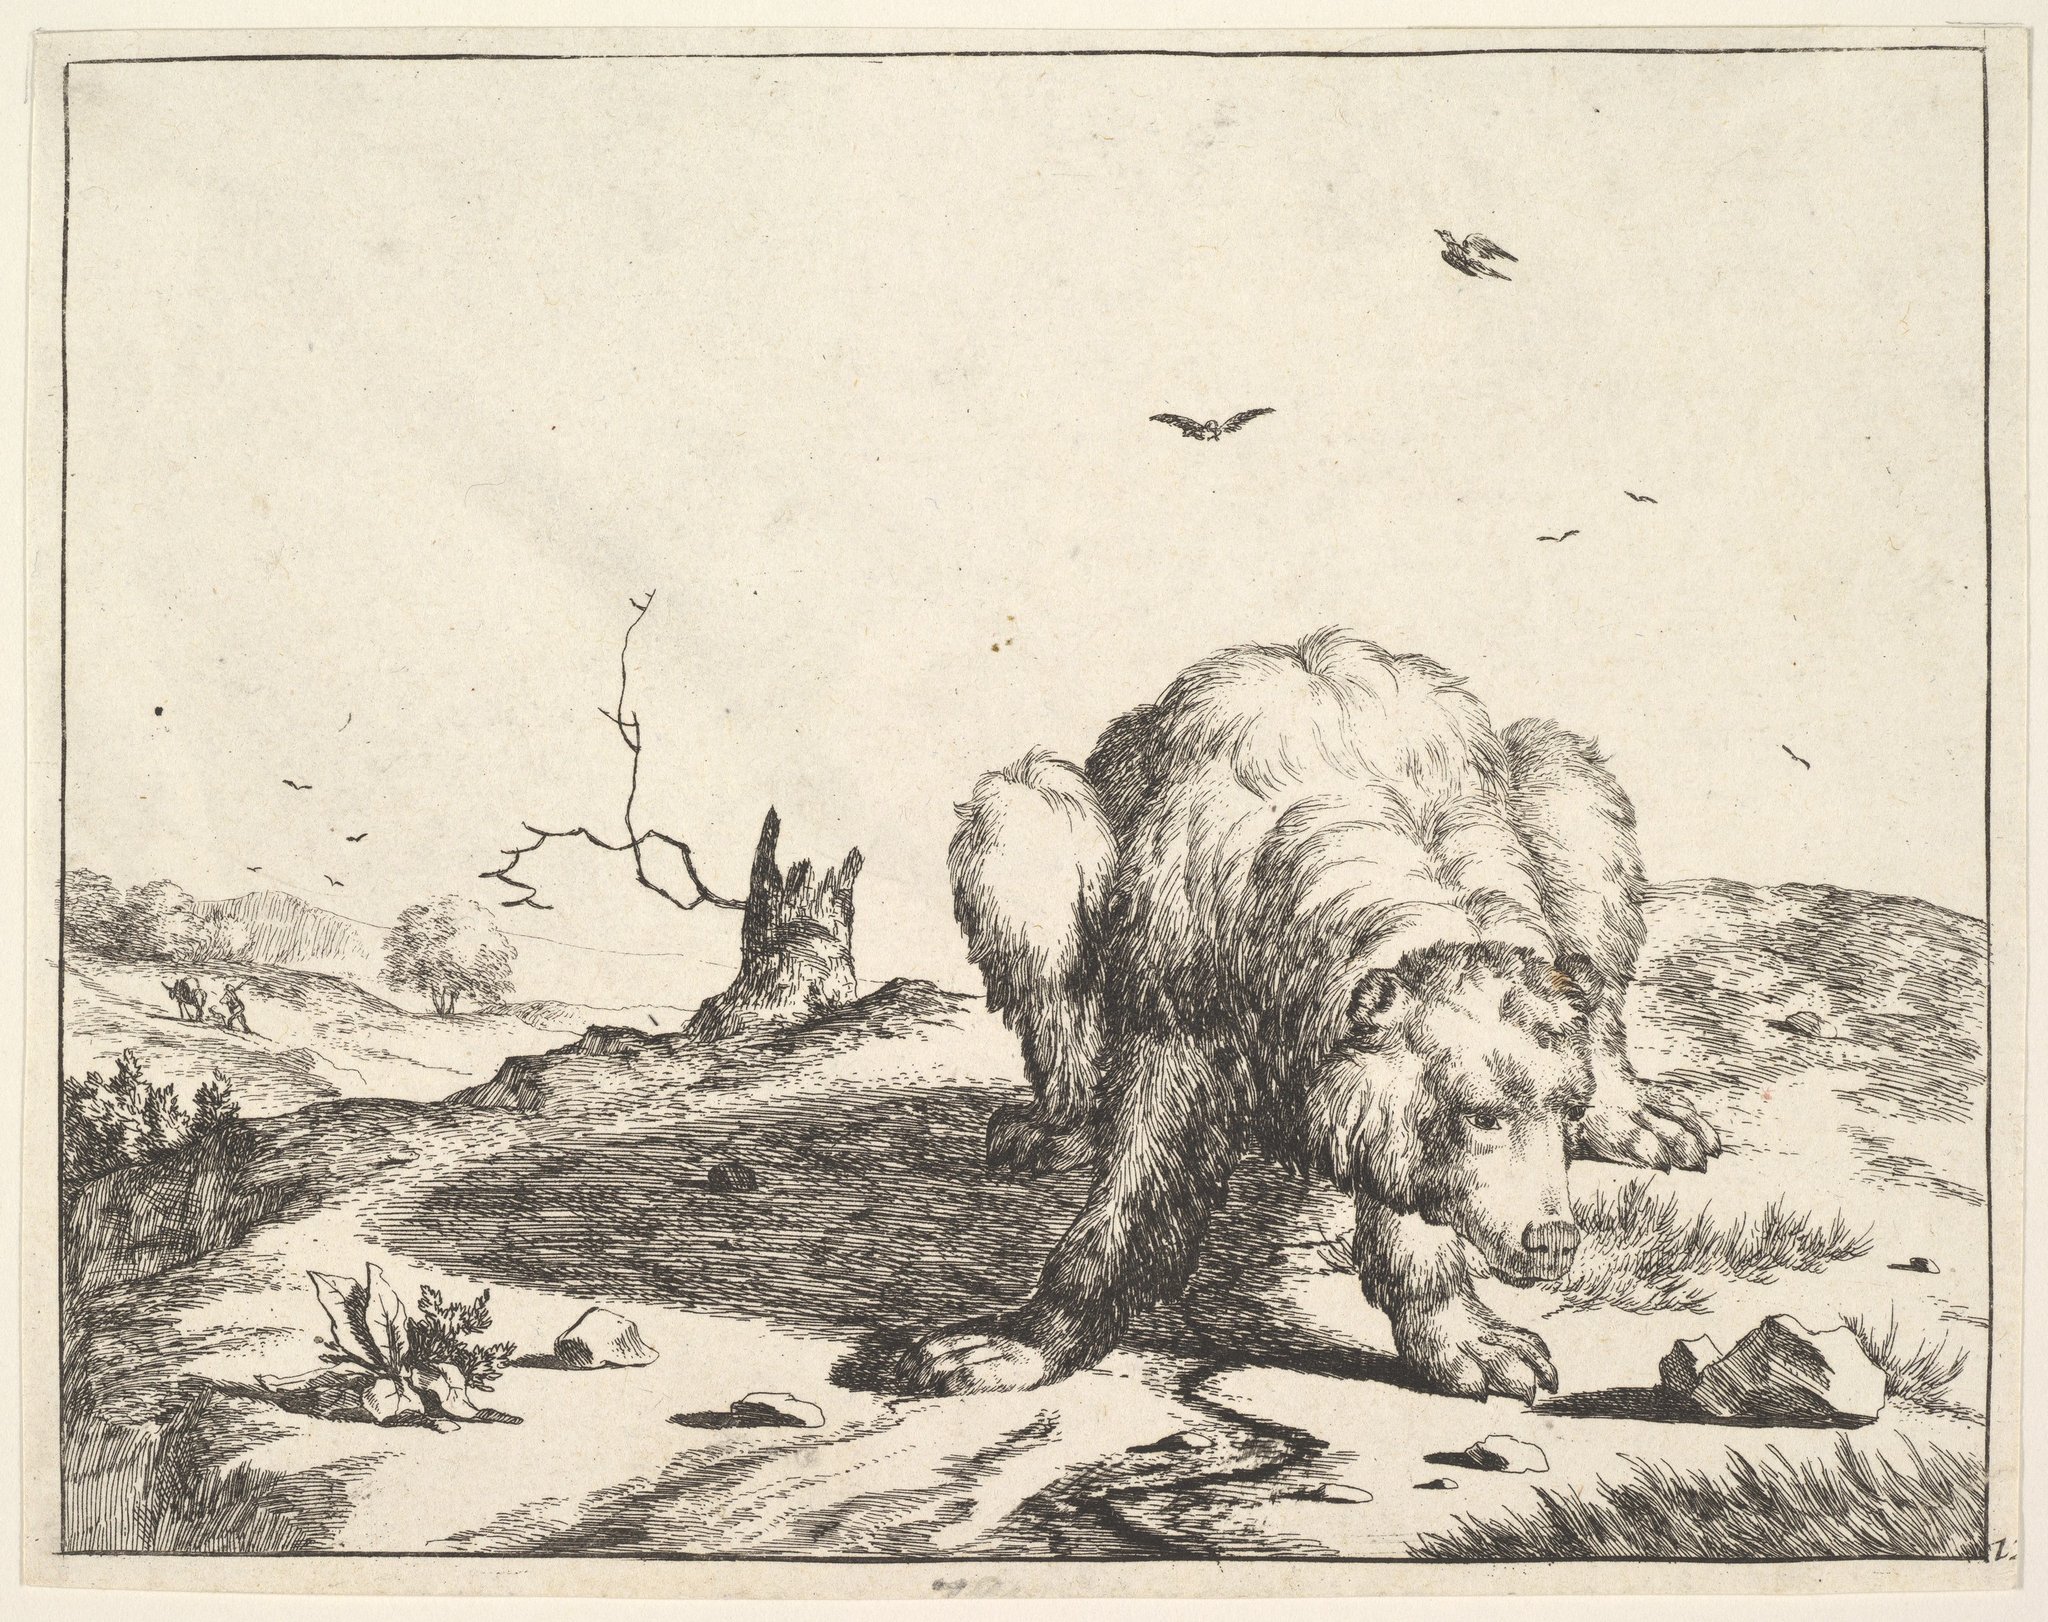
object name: print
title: Plate from "The Set of The Bears"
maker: marcus de bye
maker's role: artist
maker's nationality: dutch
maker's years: 1639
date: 1664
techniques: etching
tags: bears